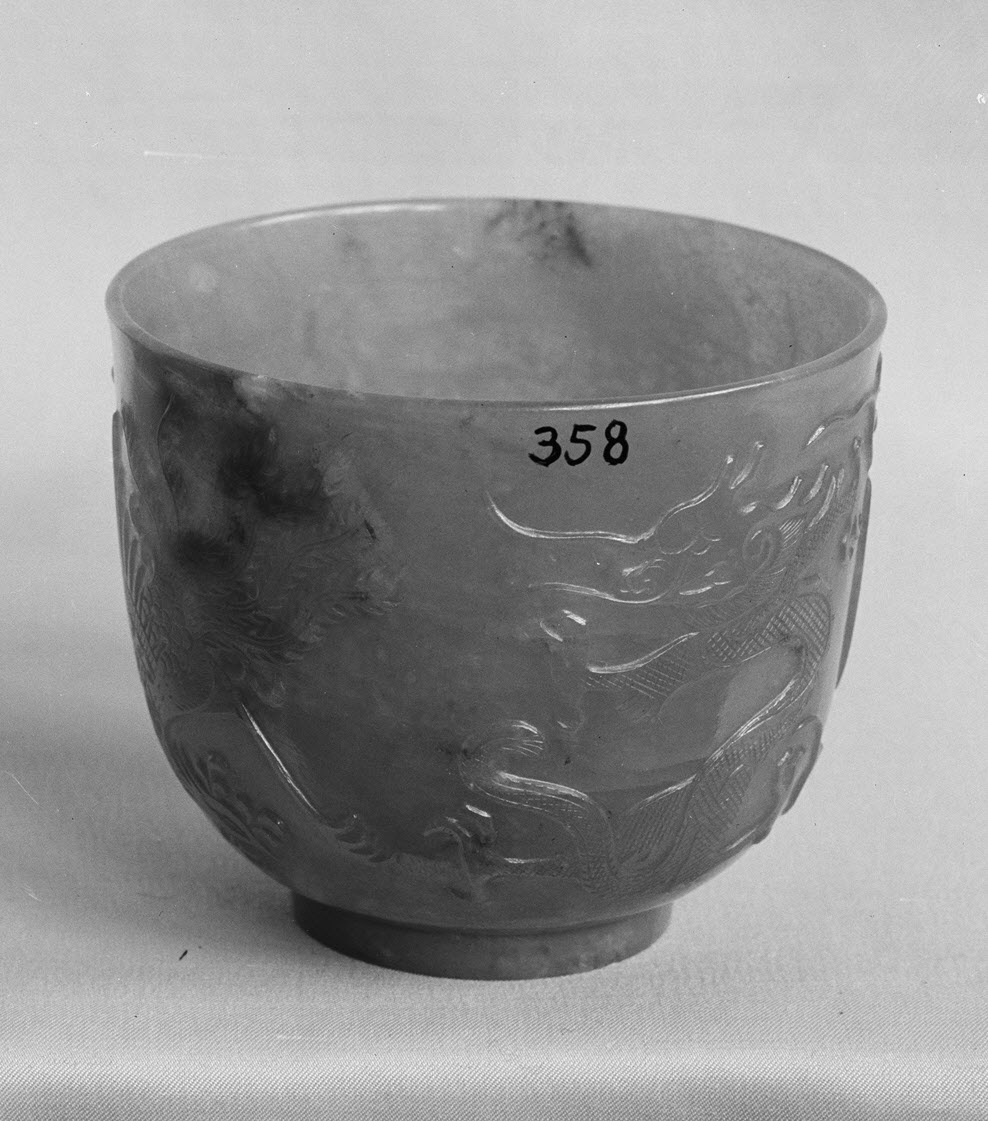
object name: cup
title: One of pair of cups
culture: chinese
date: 1368-1644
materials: jade